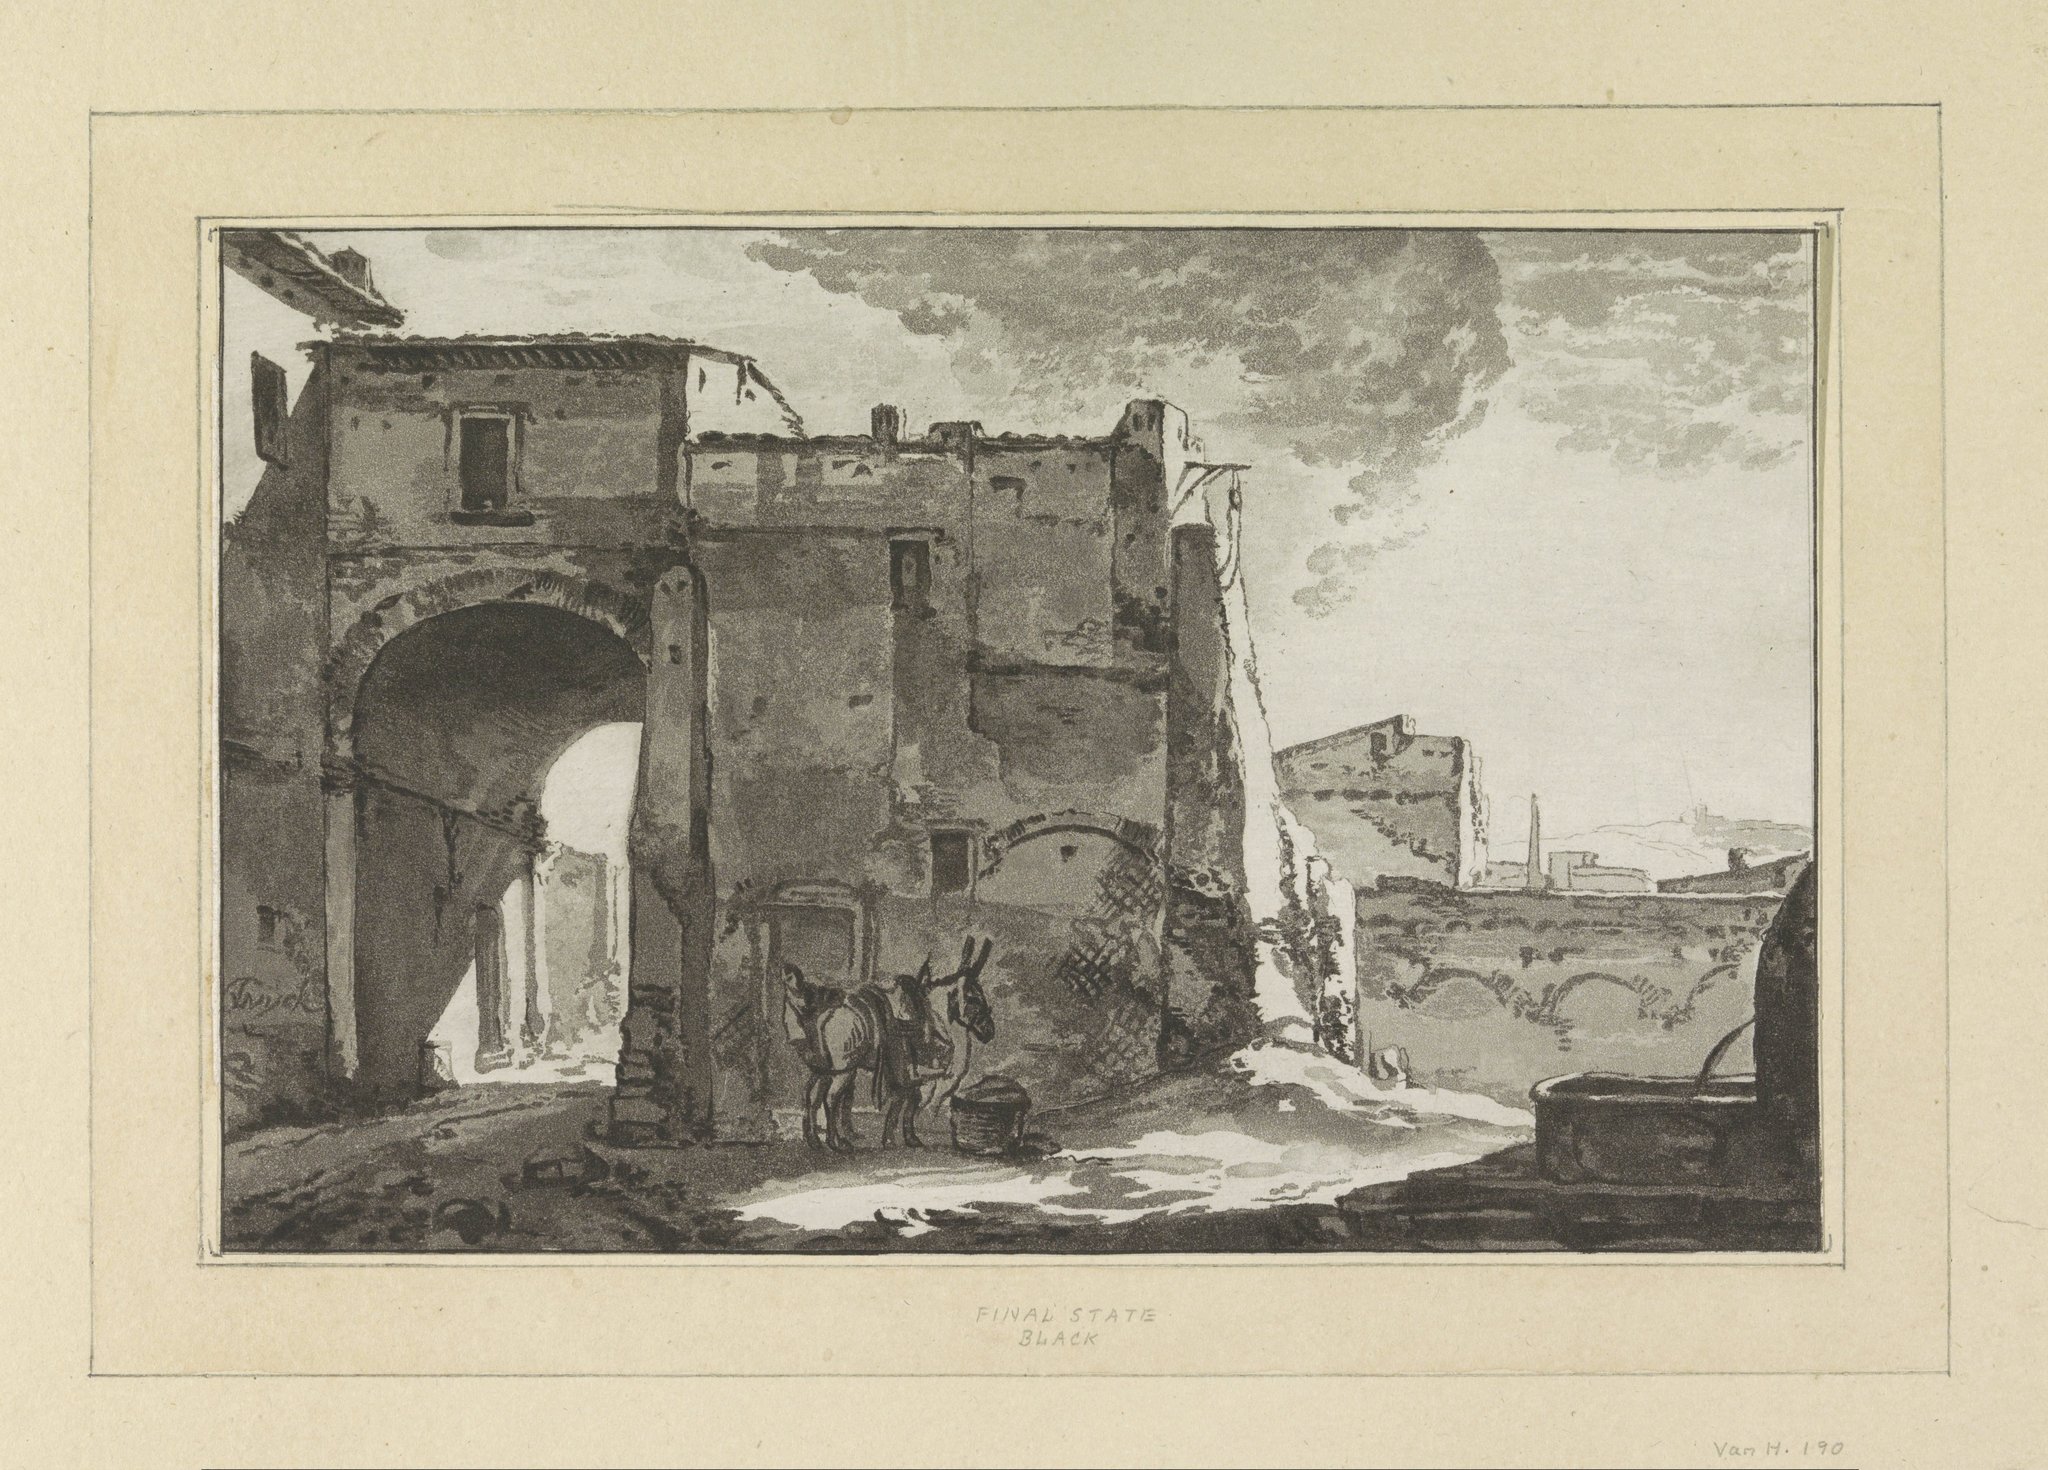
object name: print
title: Poort met reiziger en muildier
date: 1781-1782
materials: paper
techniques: etching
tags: city-view, and landscape with man-made constructions, mule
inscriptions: collector's mark: Lugt 2228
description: Bij een poort staan een man en een muildier. Rechts een waterbron.